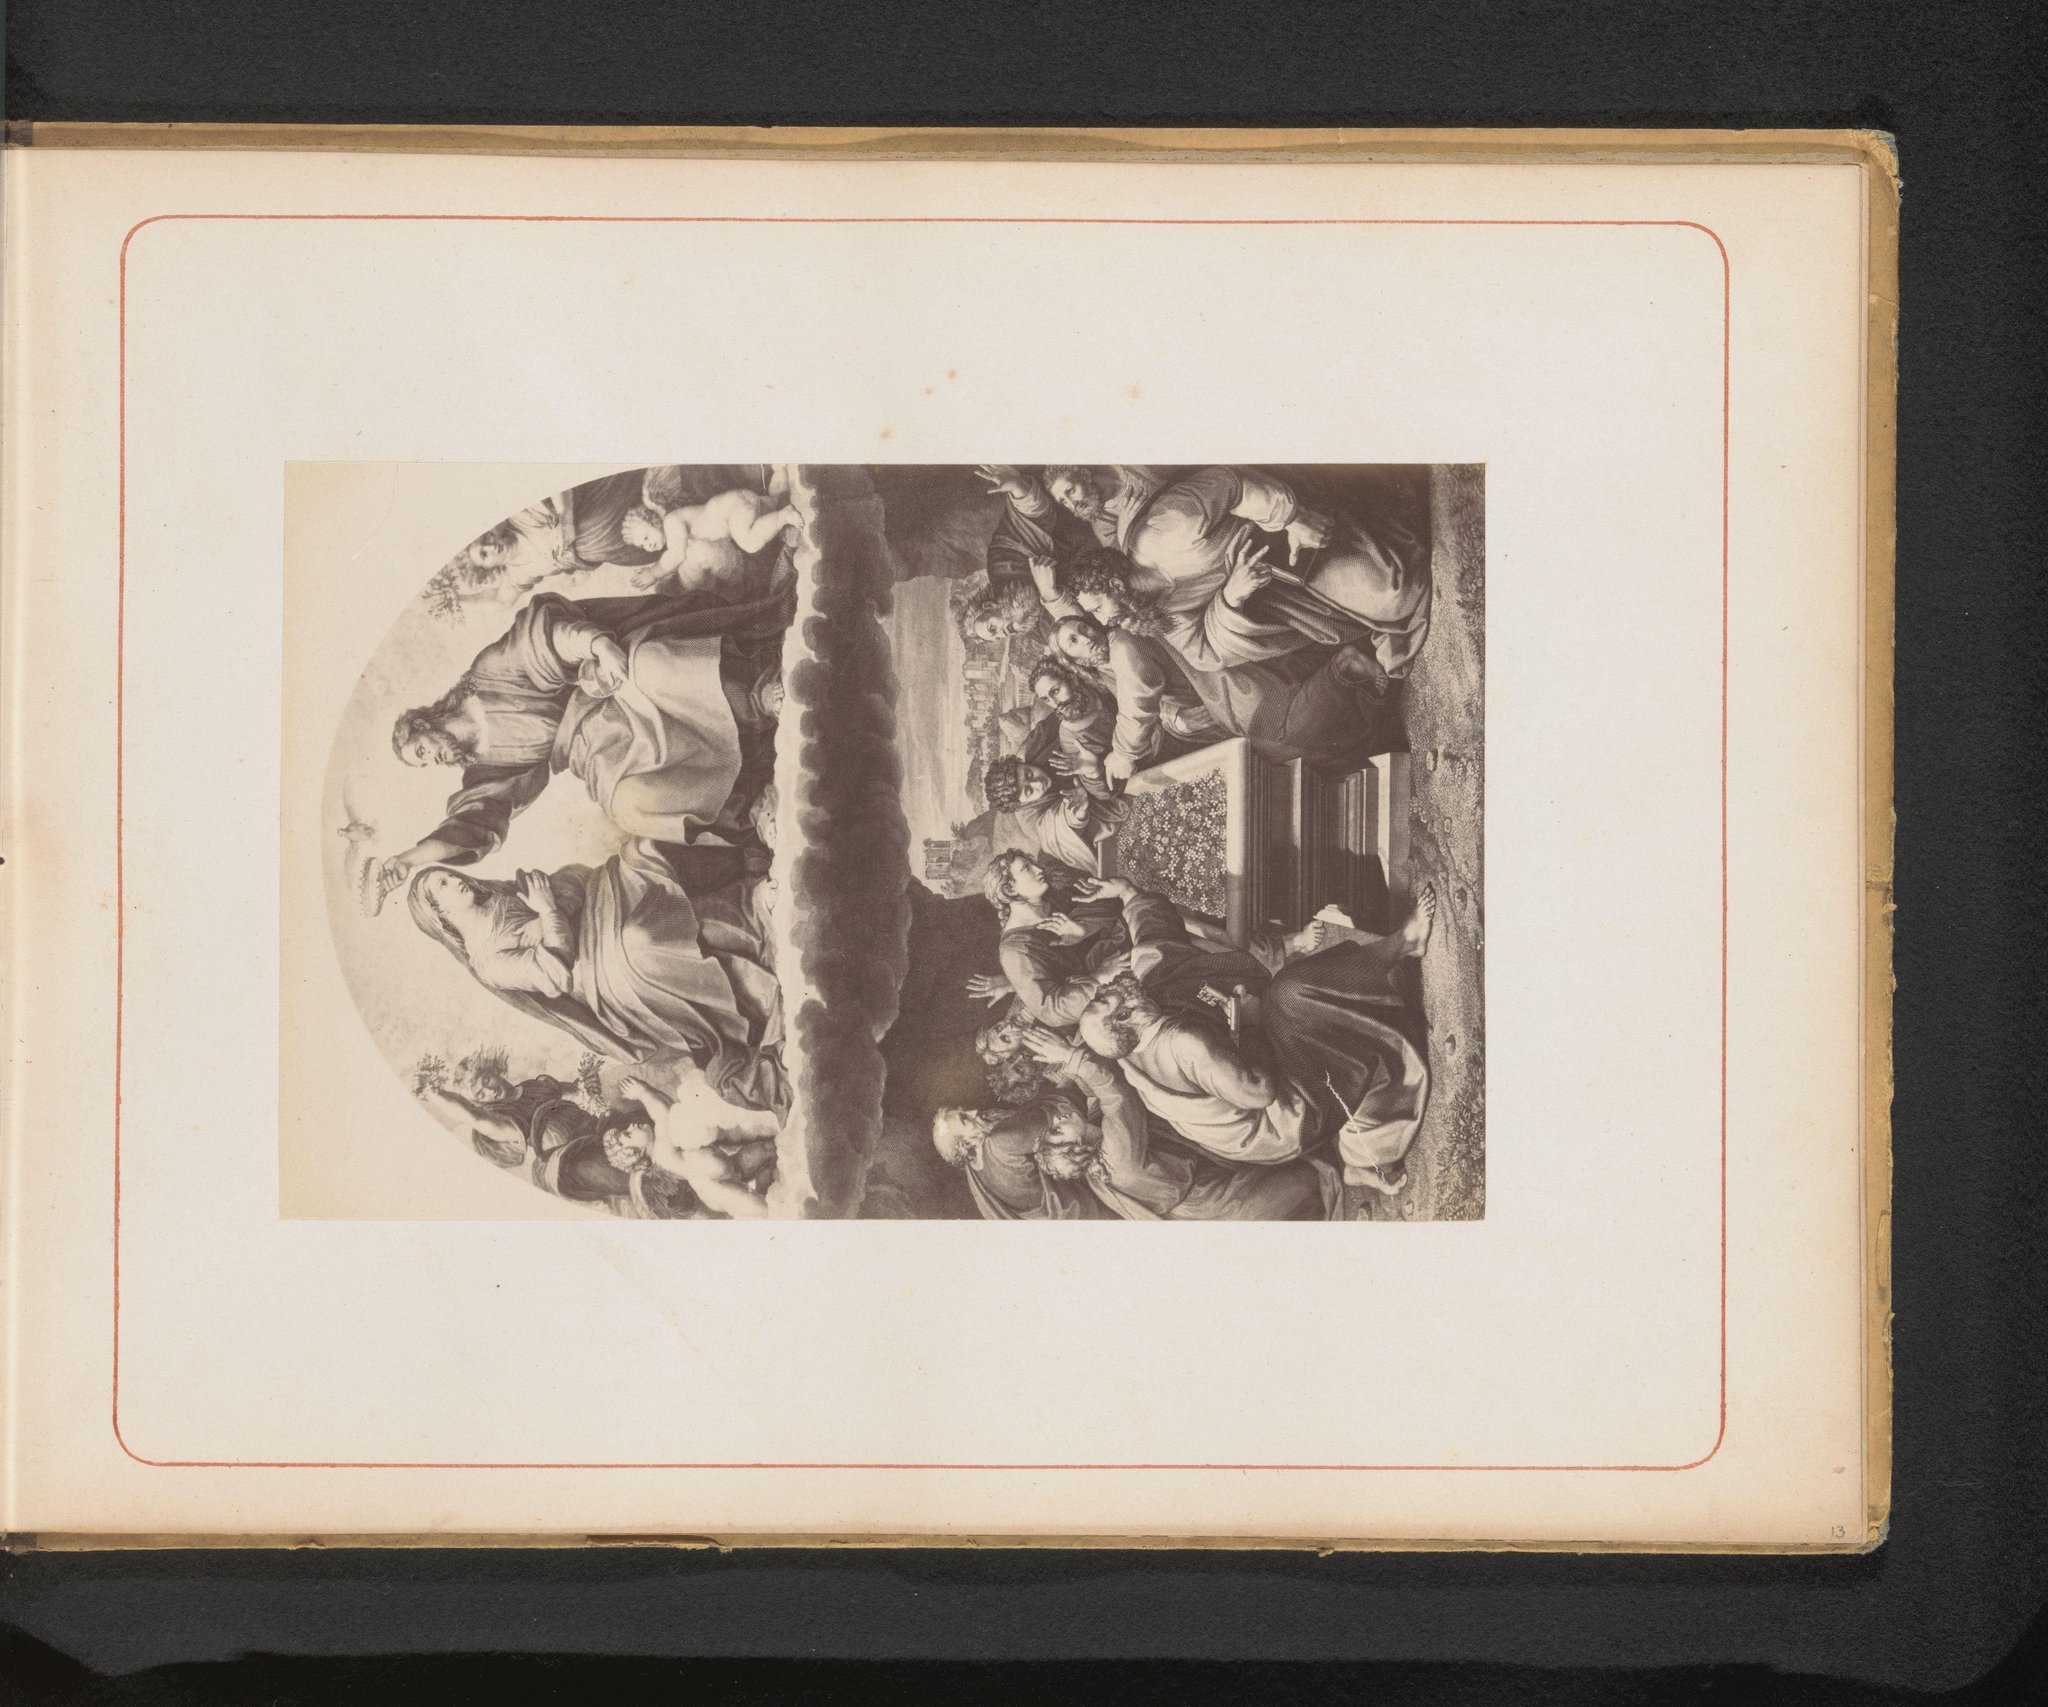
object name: photograph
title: Fotoreproductie van een gravure naar De kroning van Maria door Giulio Romano in het Vaticaan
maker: Anonymous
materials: photographic support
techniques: albumen print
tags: coronation of mary by christ